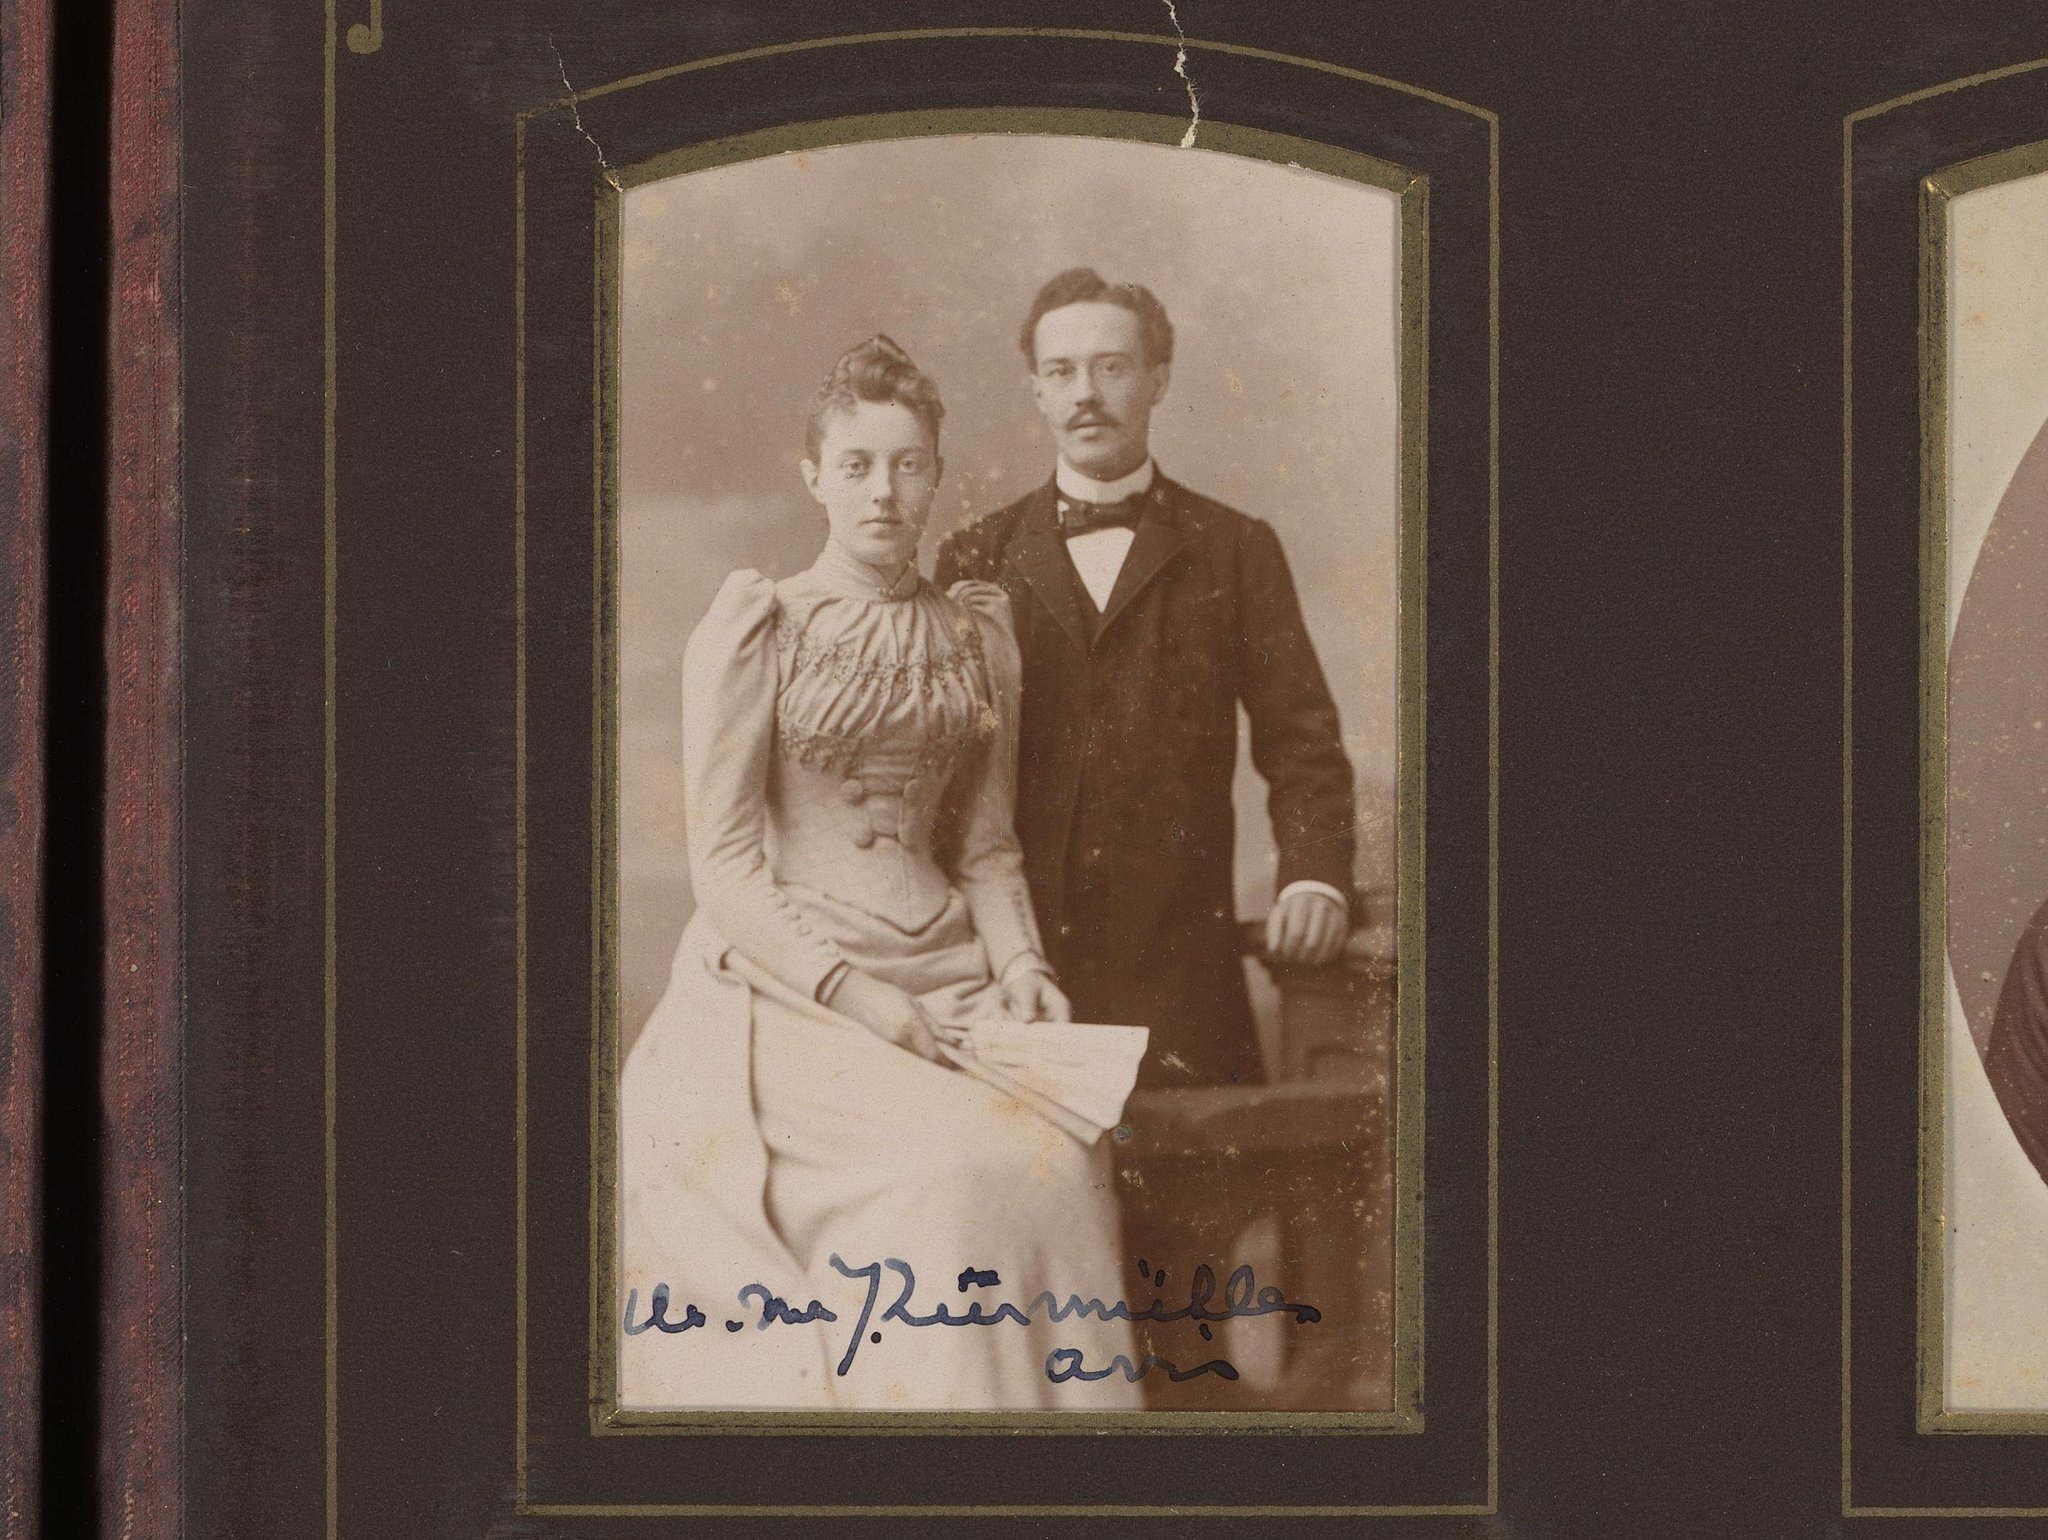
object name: album leaf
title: Portret van het echtpaar J. Zurmühlen-Aris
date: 1886-1907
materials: cardboard, paper, photographic support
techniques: daylight paper print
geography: amsterdam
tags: historical persons, marriage, married couple, 'matrimonium', amsterdam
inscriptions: address: ‘Amsterdam Heerengracht 150. Batavia.’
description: Onderdeel van Fotoalbum van de families Matthes, Doorman en Van Thiel.